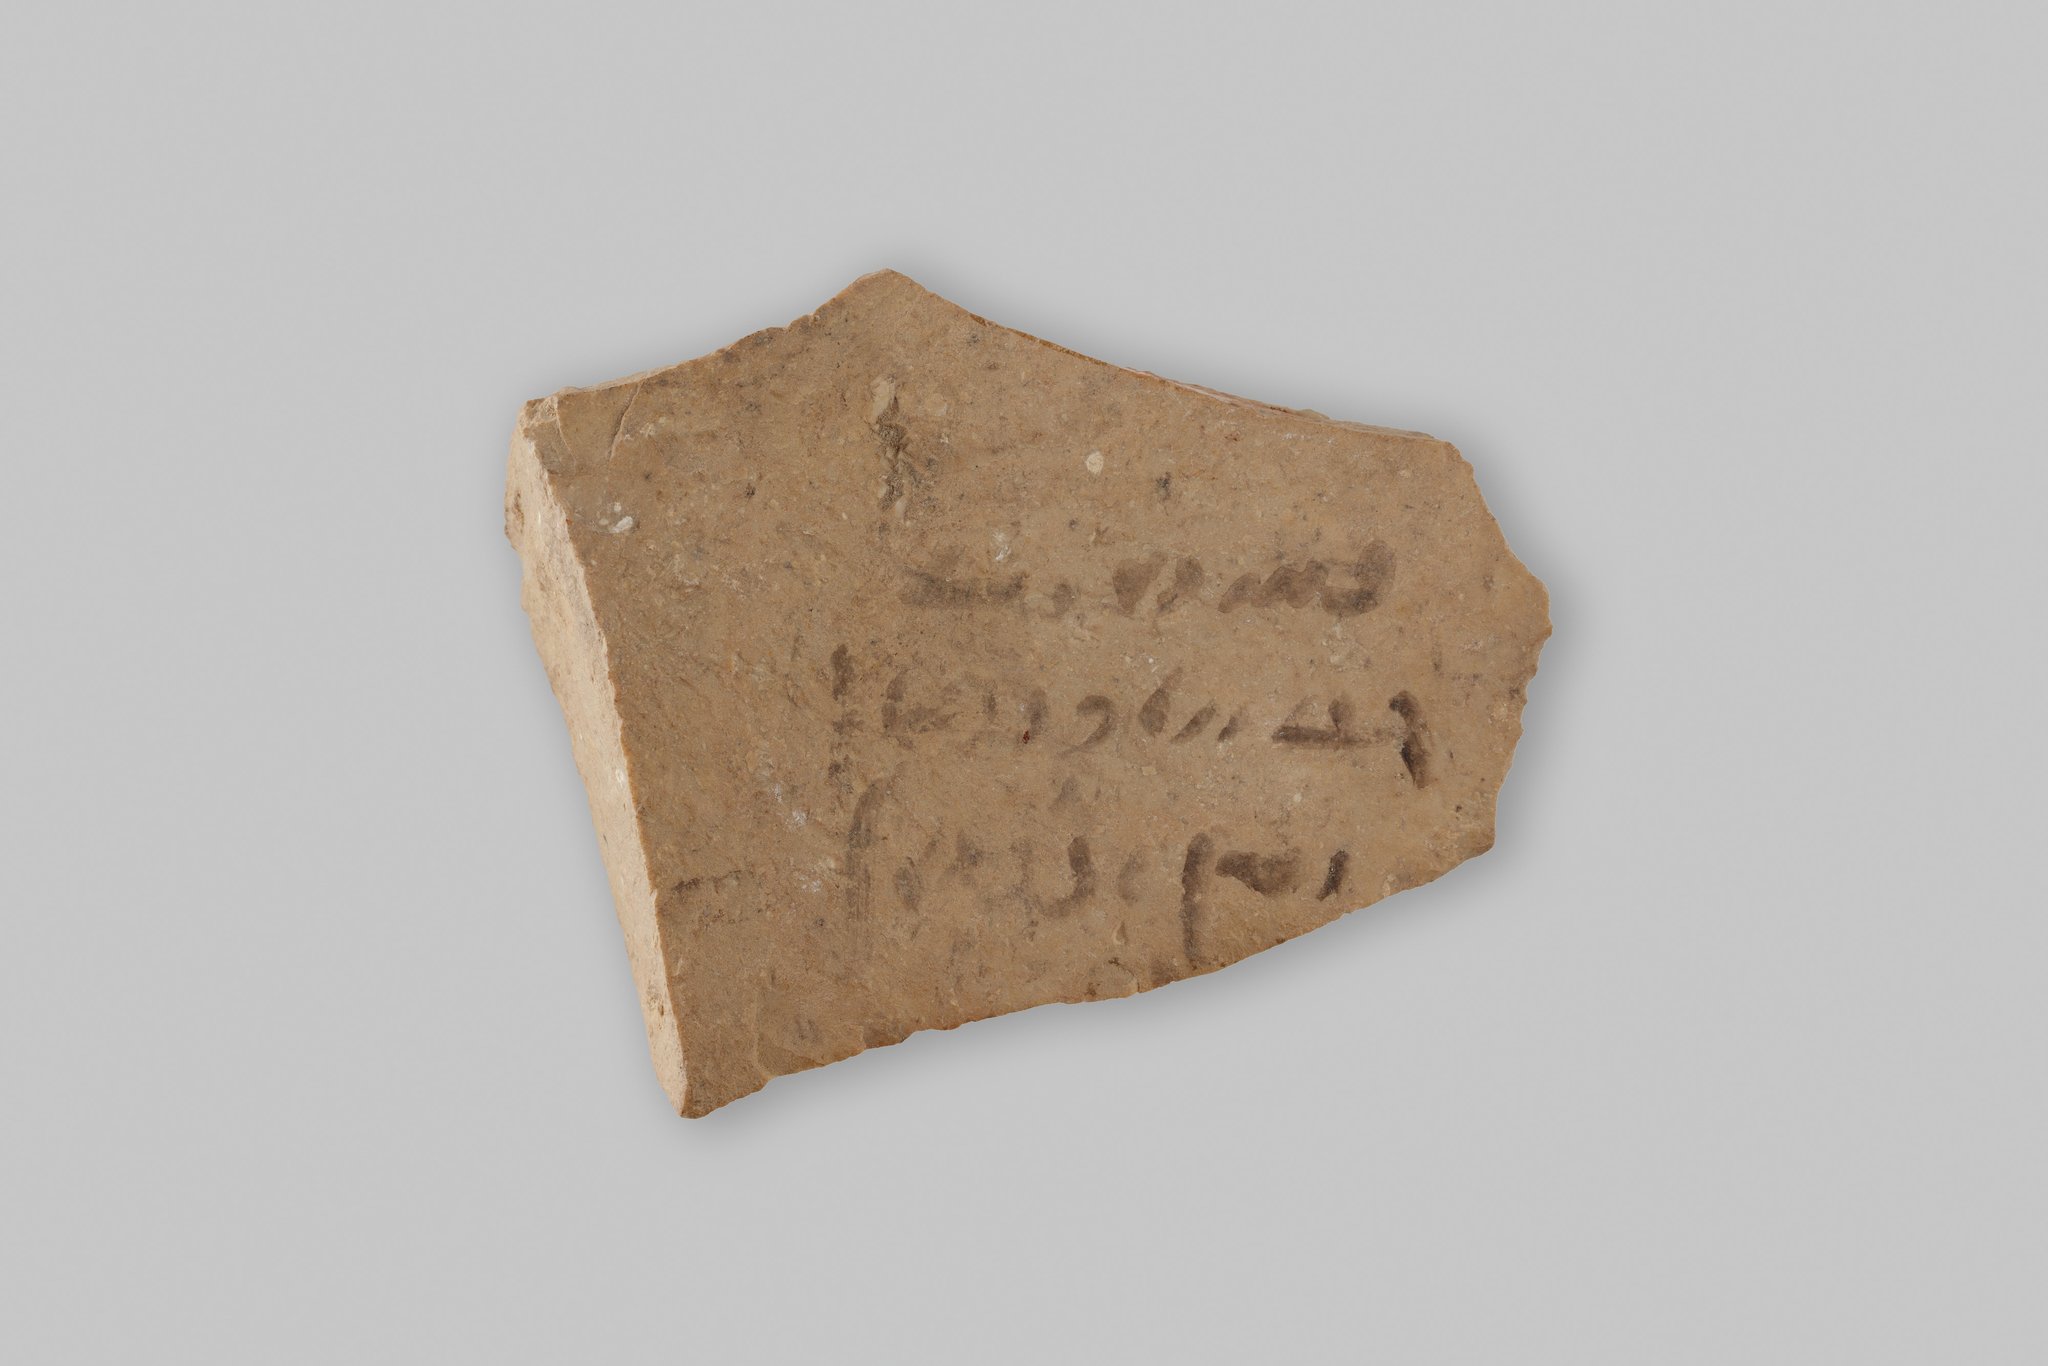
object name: ostracon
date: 400-30 BCE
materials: ink, stone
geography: egypt